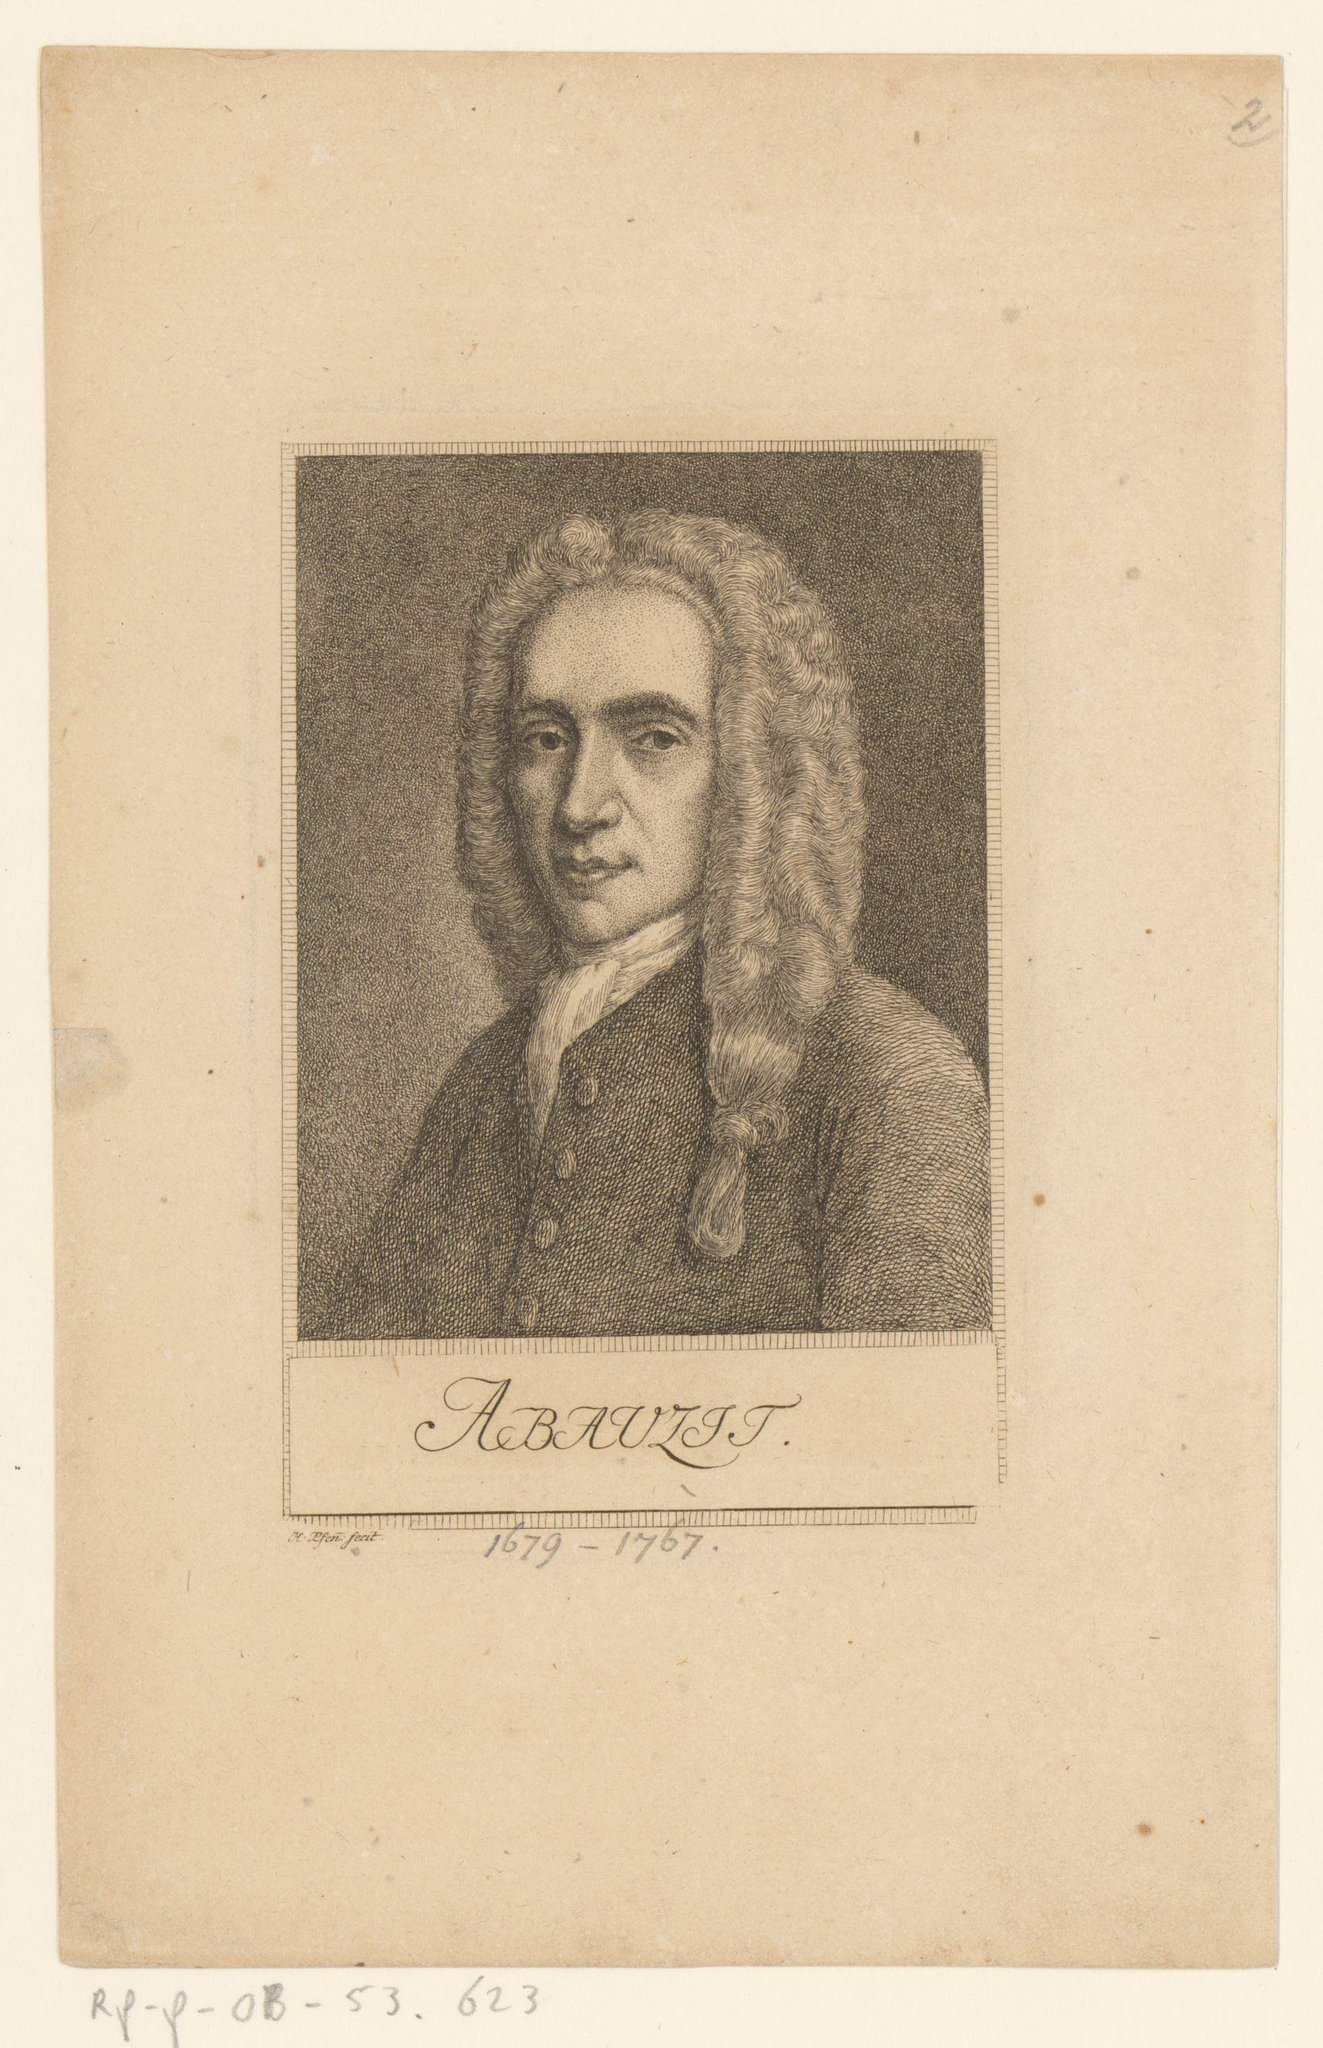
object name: print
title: Portret van Firmin Abauzit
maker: heinrich pfenninger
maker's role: print maker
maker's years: 1749-1815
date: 1759-1815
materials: paper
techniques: engraving, etching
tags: historical persons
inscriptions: date